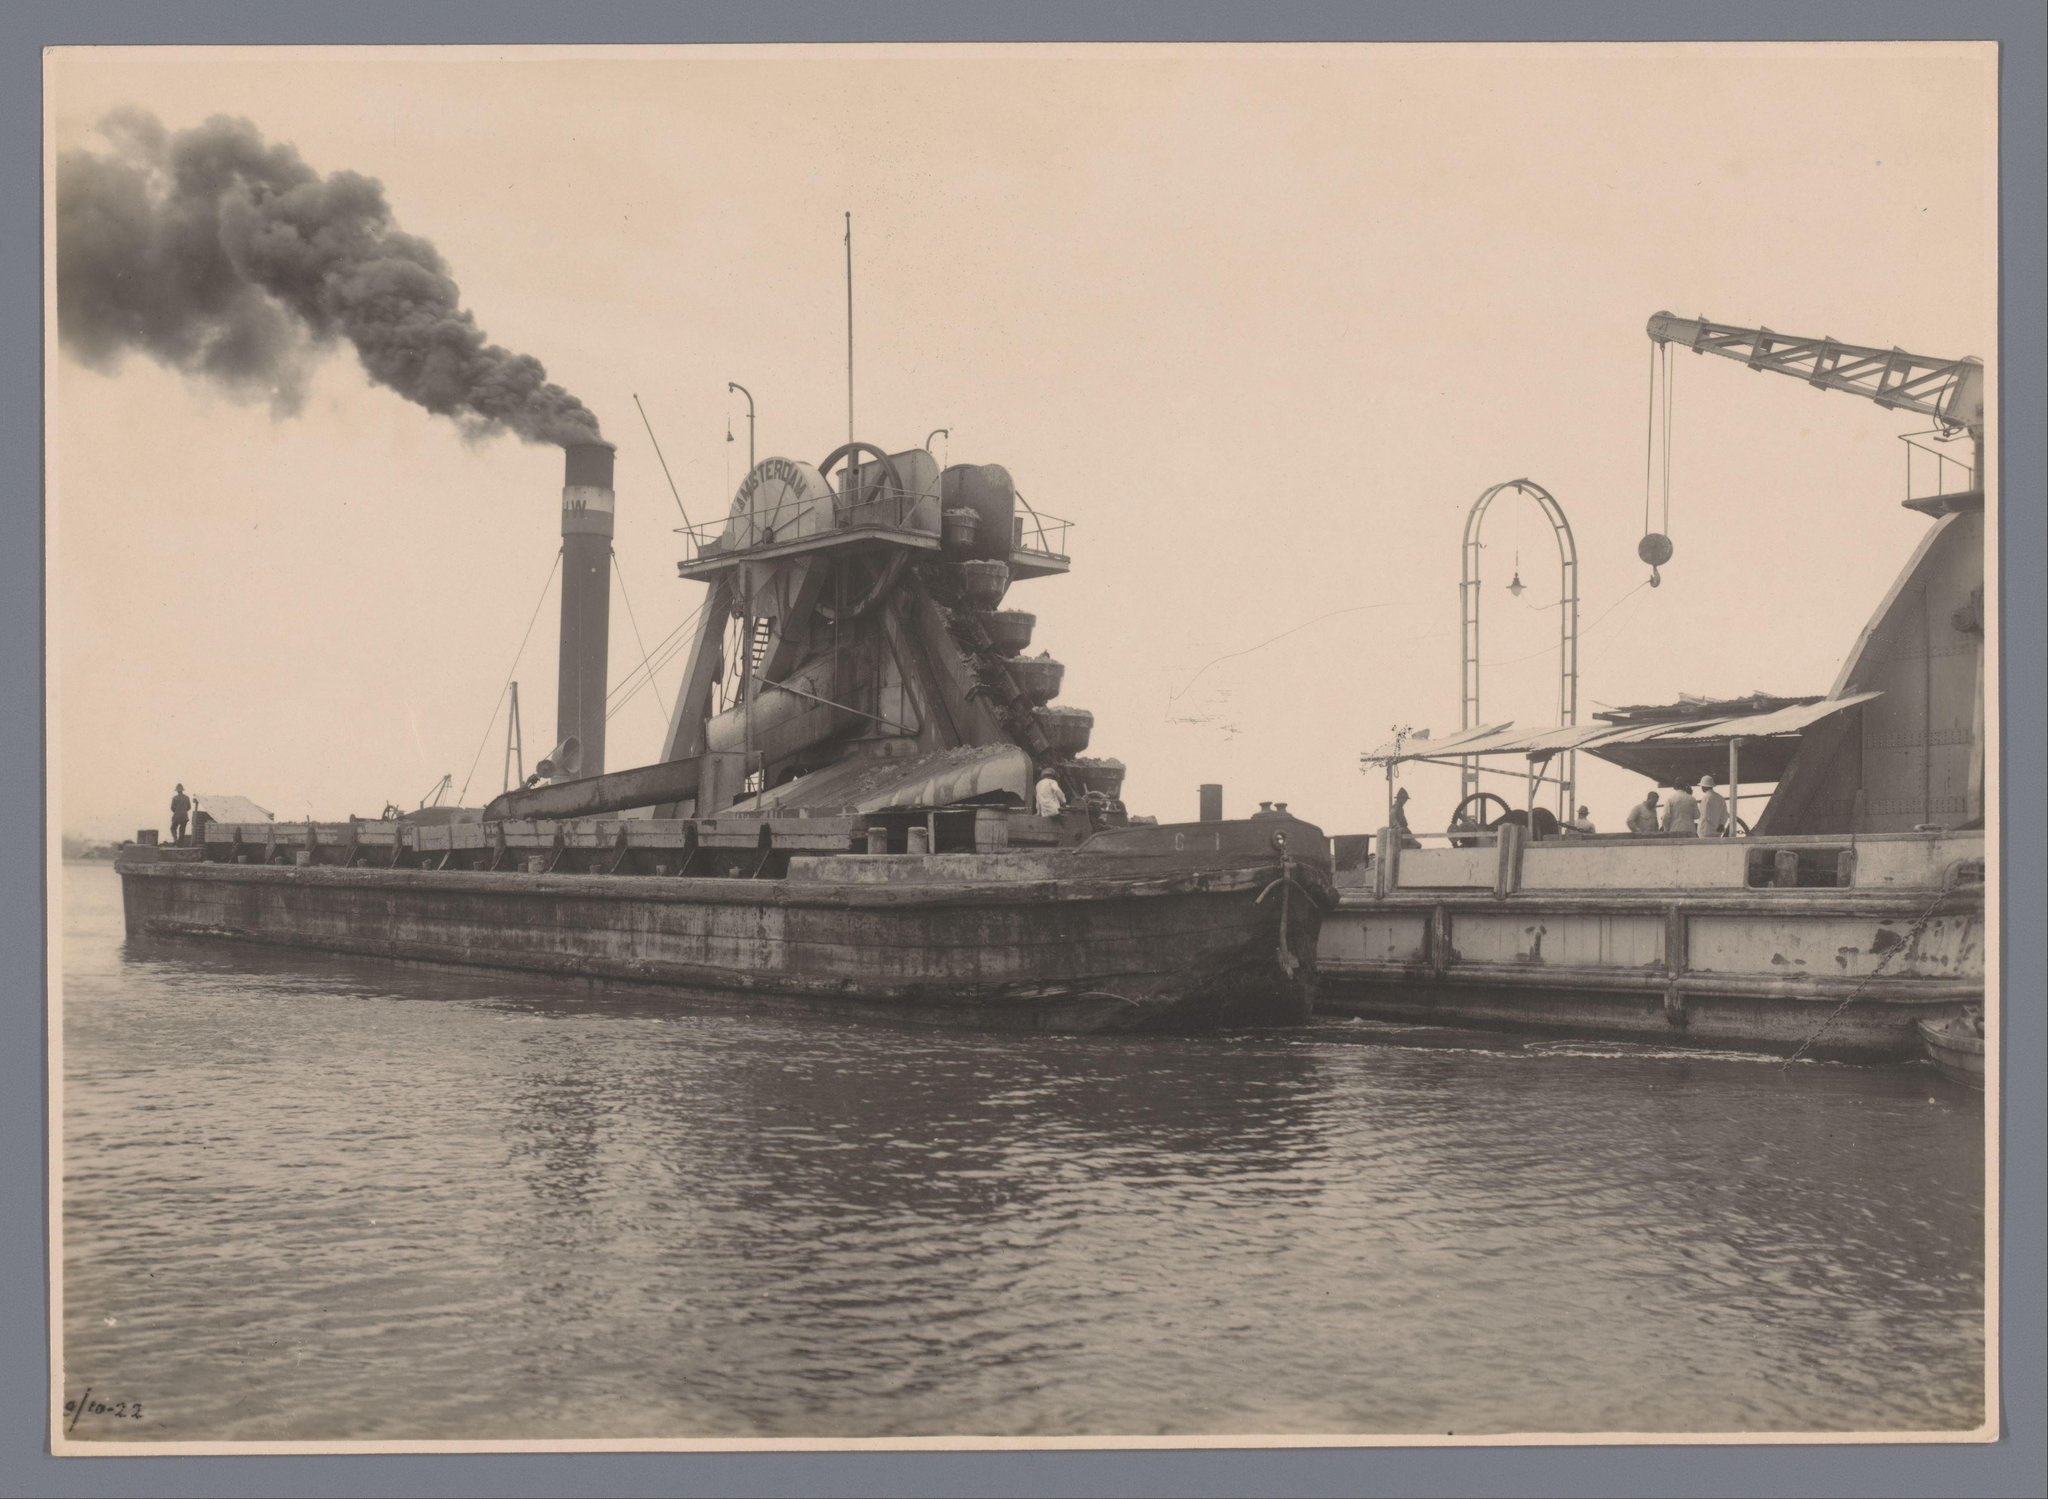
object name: photograph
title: Oceaanhaven Belawan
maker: Anonymous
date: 1922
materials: photographic support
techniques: gelatin silver print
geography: belawan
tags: dredge, dredging machine, building-site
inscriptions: date: ‘9/10-22’, inscription: ‘No. 240 Baggermolen Amsterdam’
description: De baggermolen 'Amsterdam' op het water naast een ander schip. Genummerd: 240. Onderdeel van de groep van losse foto's over de aanleg van de haven Belawan aan de kust voor Medan, Sumatra 1921-1922.